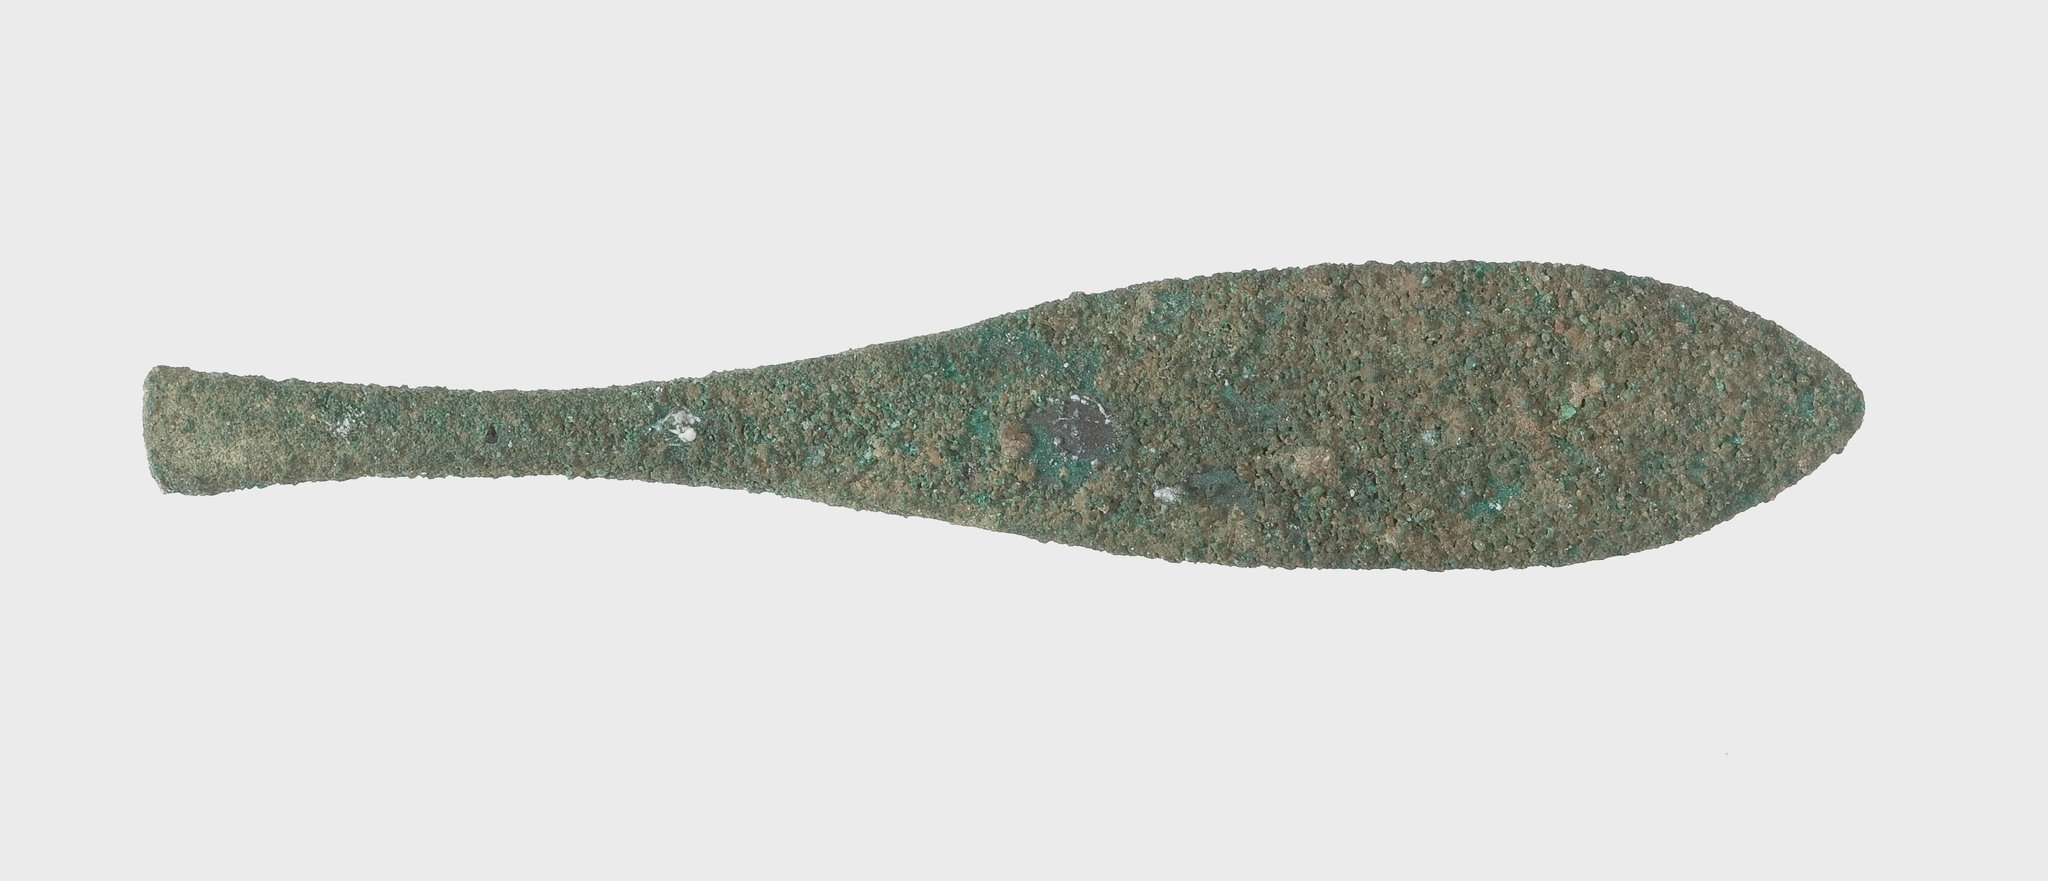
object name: knife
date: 1390-1352 BCE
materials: bronze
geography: egypt